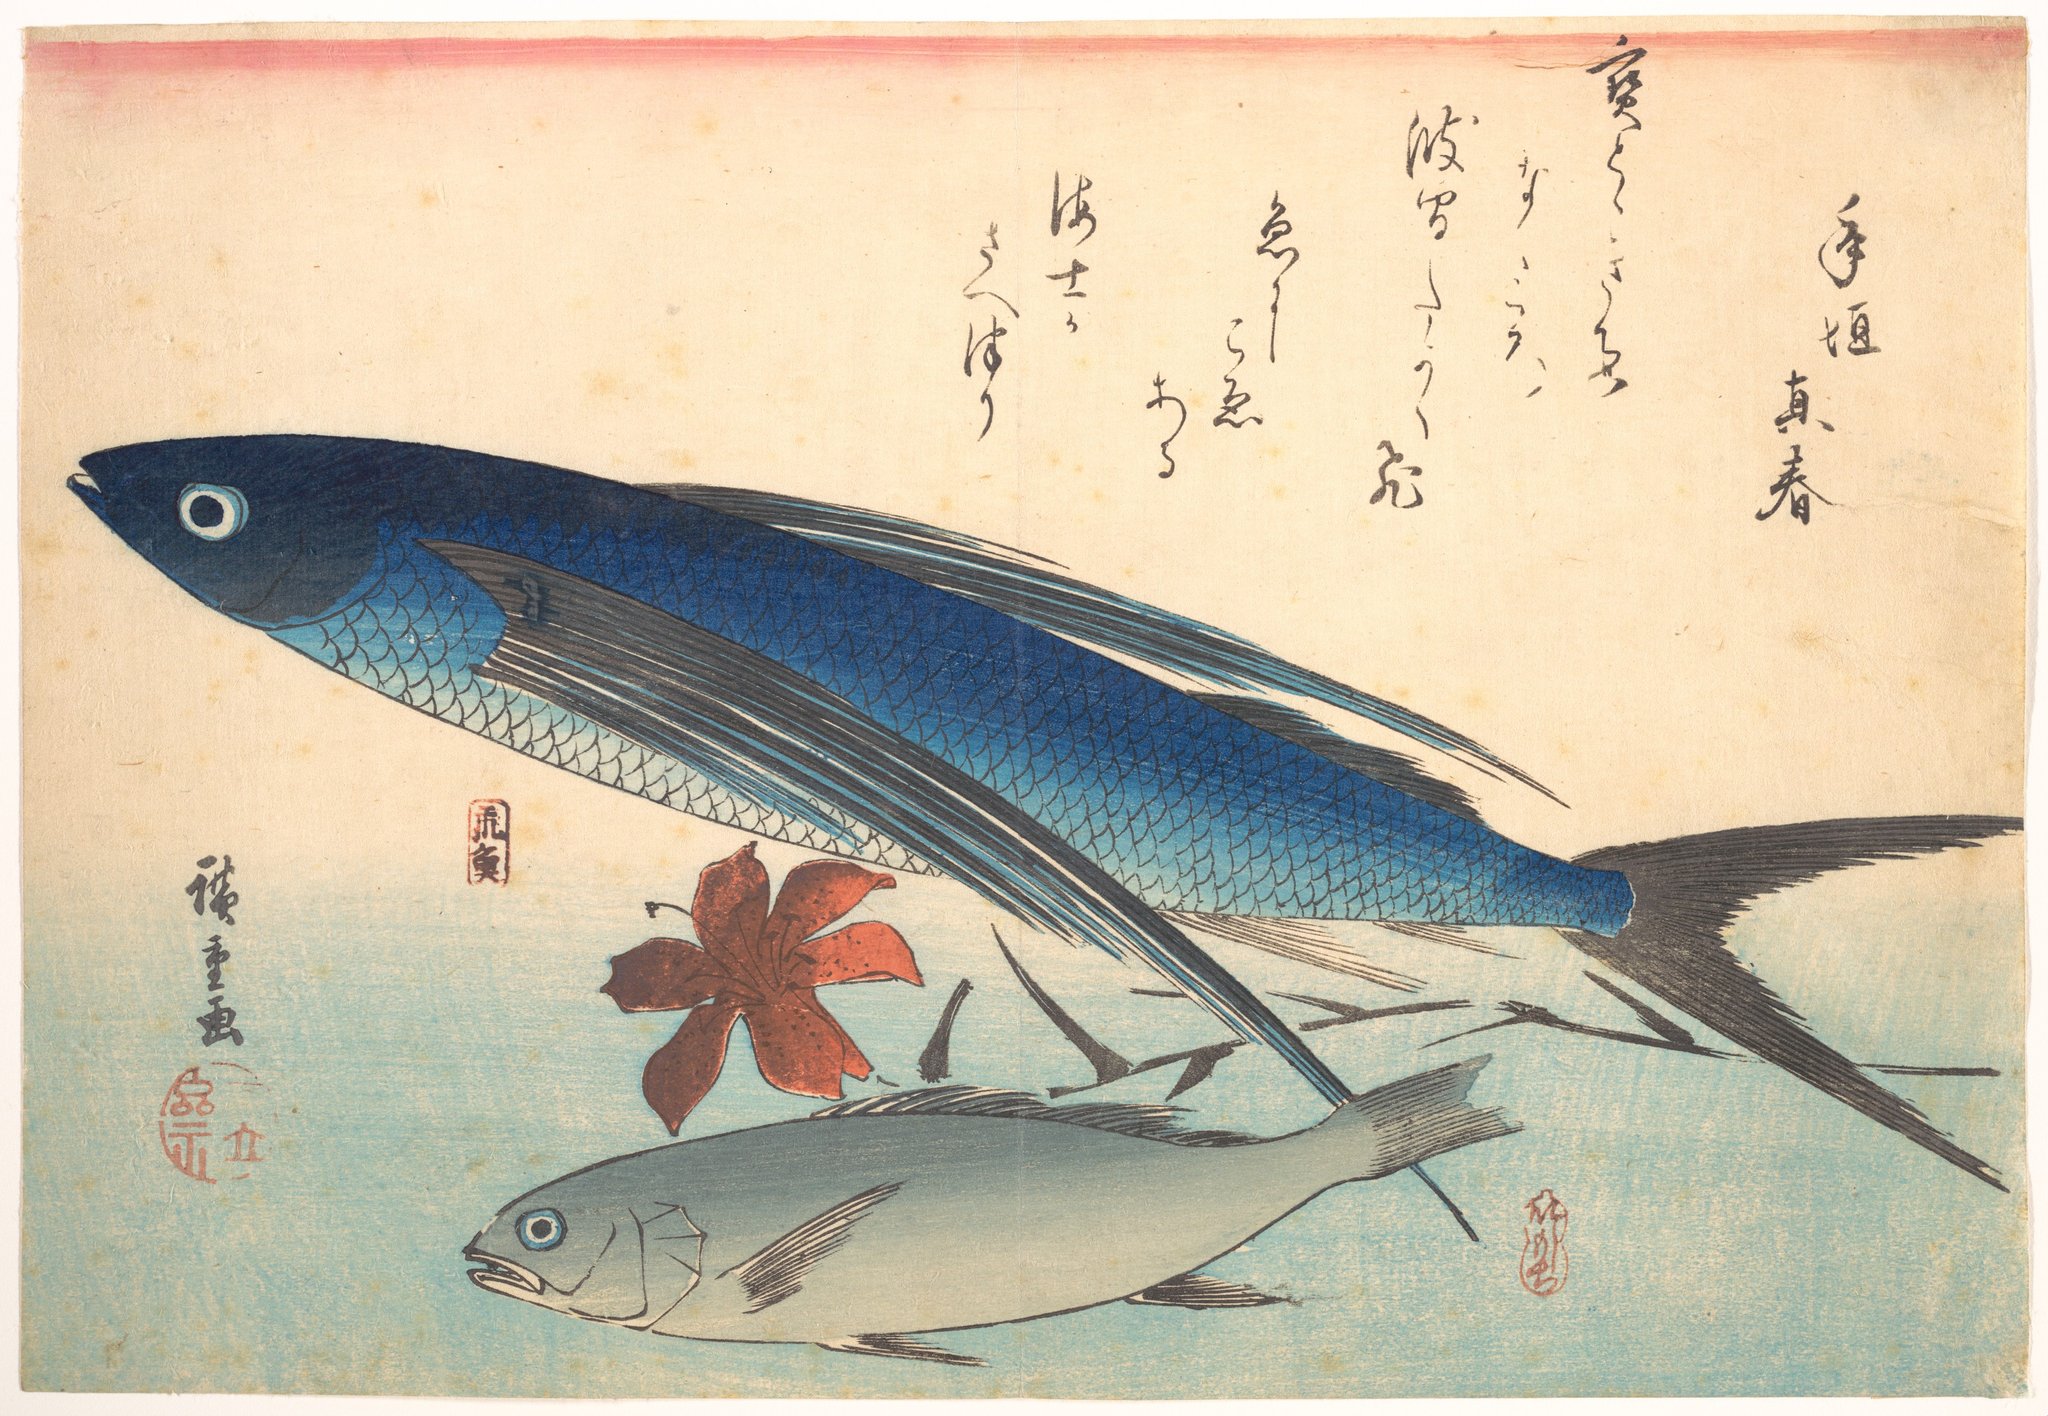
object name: woodblock print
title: Tobiuo and Ishimochi Fish, from the series Uozukushi (Every Variety of Fish)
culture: japanese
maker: utagawa hiroshige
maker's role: artist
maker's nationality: japanese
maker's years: 1797-1858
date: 1840-1849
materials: ink, paper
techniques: woodblock print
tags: fish